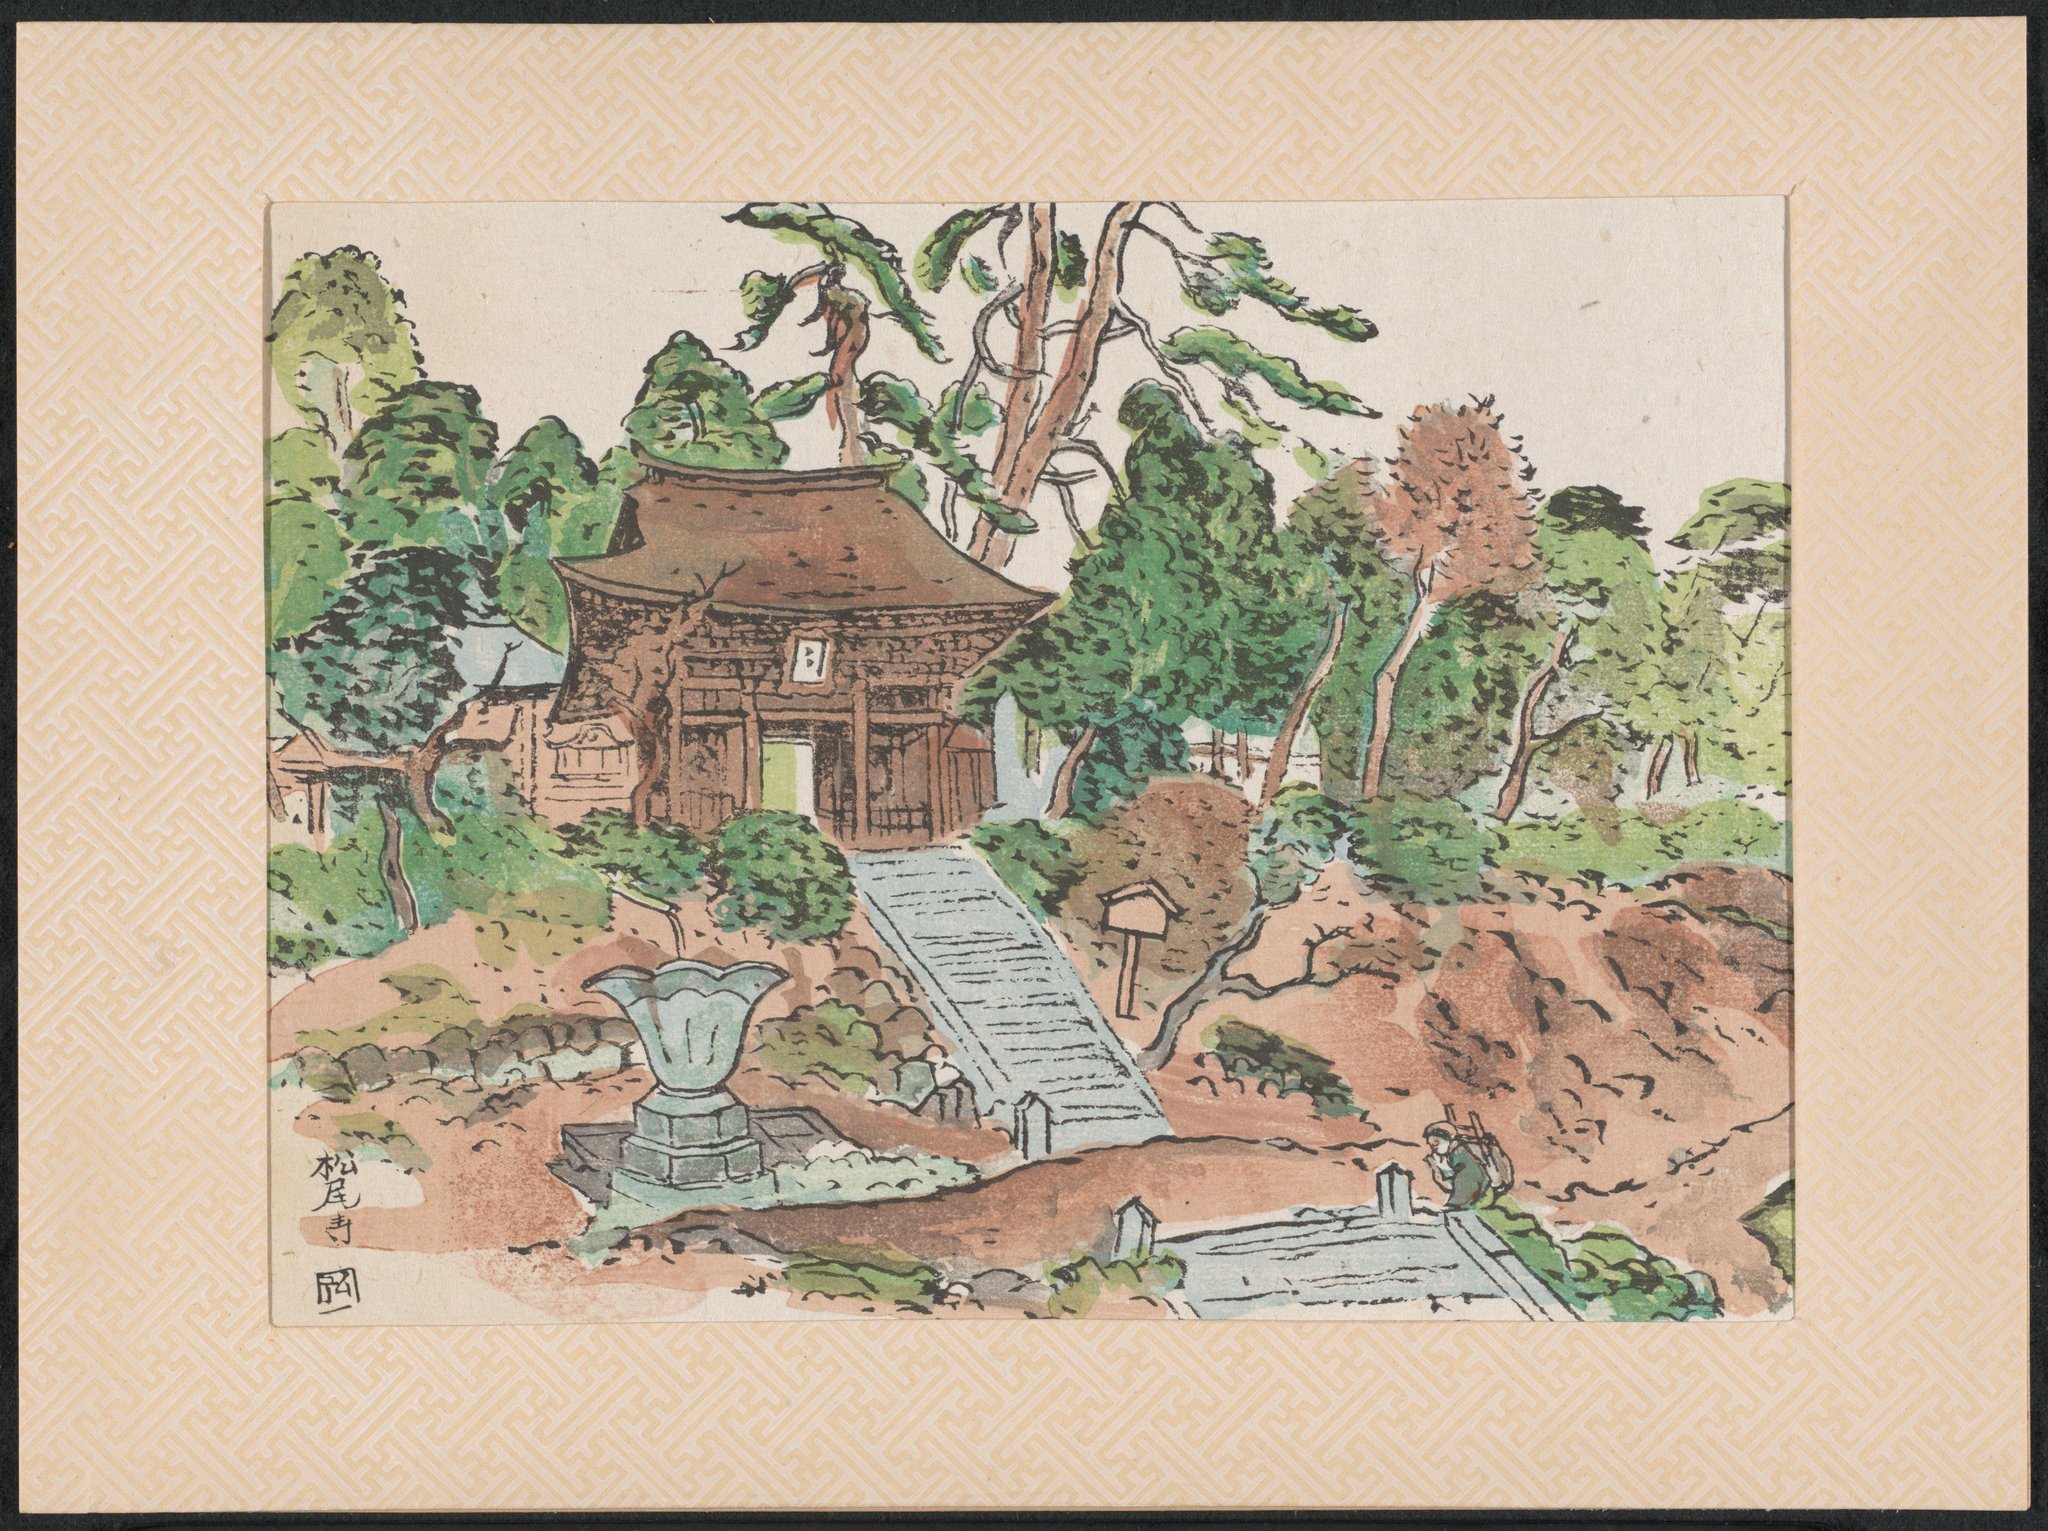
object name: print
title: Houtsnedes van heilige Kannon tempels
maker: nakazawa hiromitsu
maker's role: print maker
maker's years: 1874-1964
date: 1920-1930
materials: paper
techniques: woodcut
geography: japan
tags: temple, shrine ~ hinduism, buddhism, jainism, front steps, kyoto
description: Gezicht op de Matsunodera tempel in het noorden van het Kyoto prefectuur. Op de voorgrond trappen die leiden naar de ingang van de tempel.